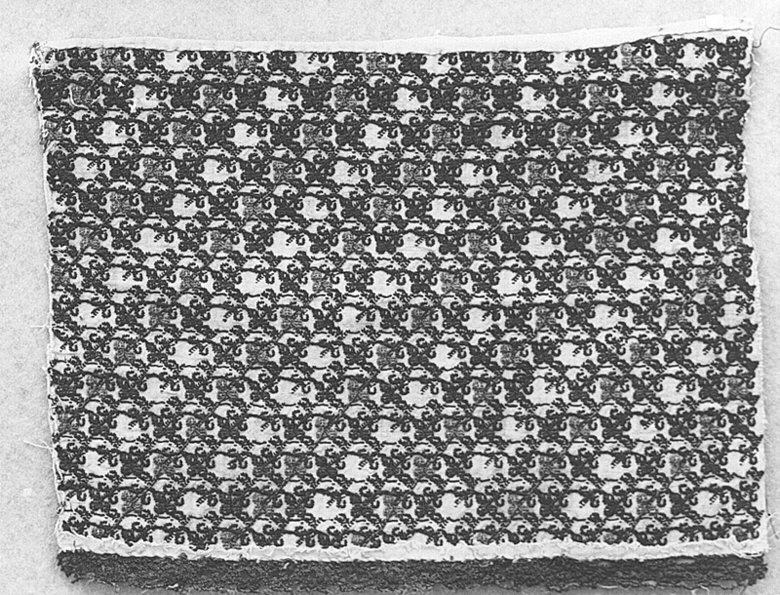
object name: textile fragment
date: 1801-1833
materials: linen, silk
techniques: embroidery, weave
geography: greece